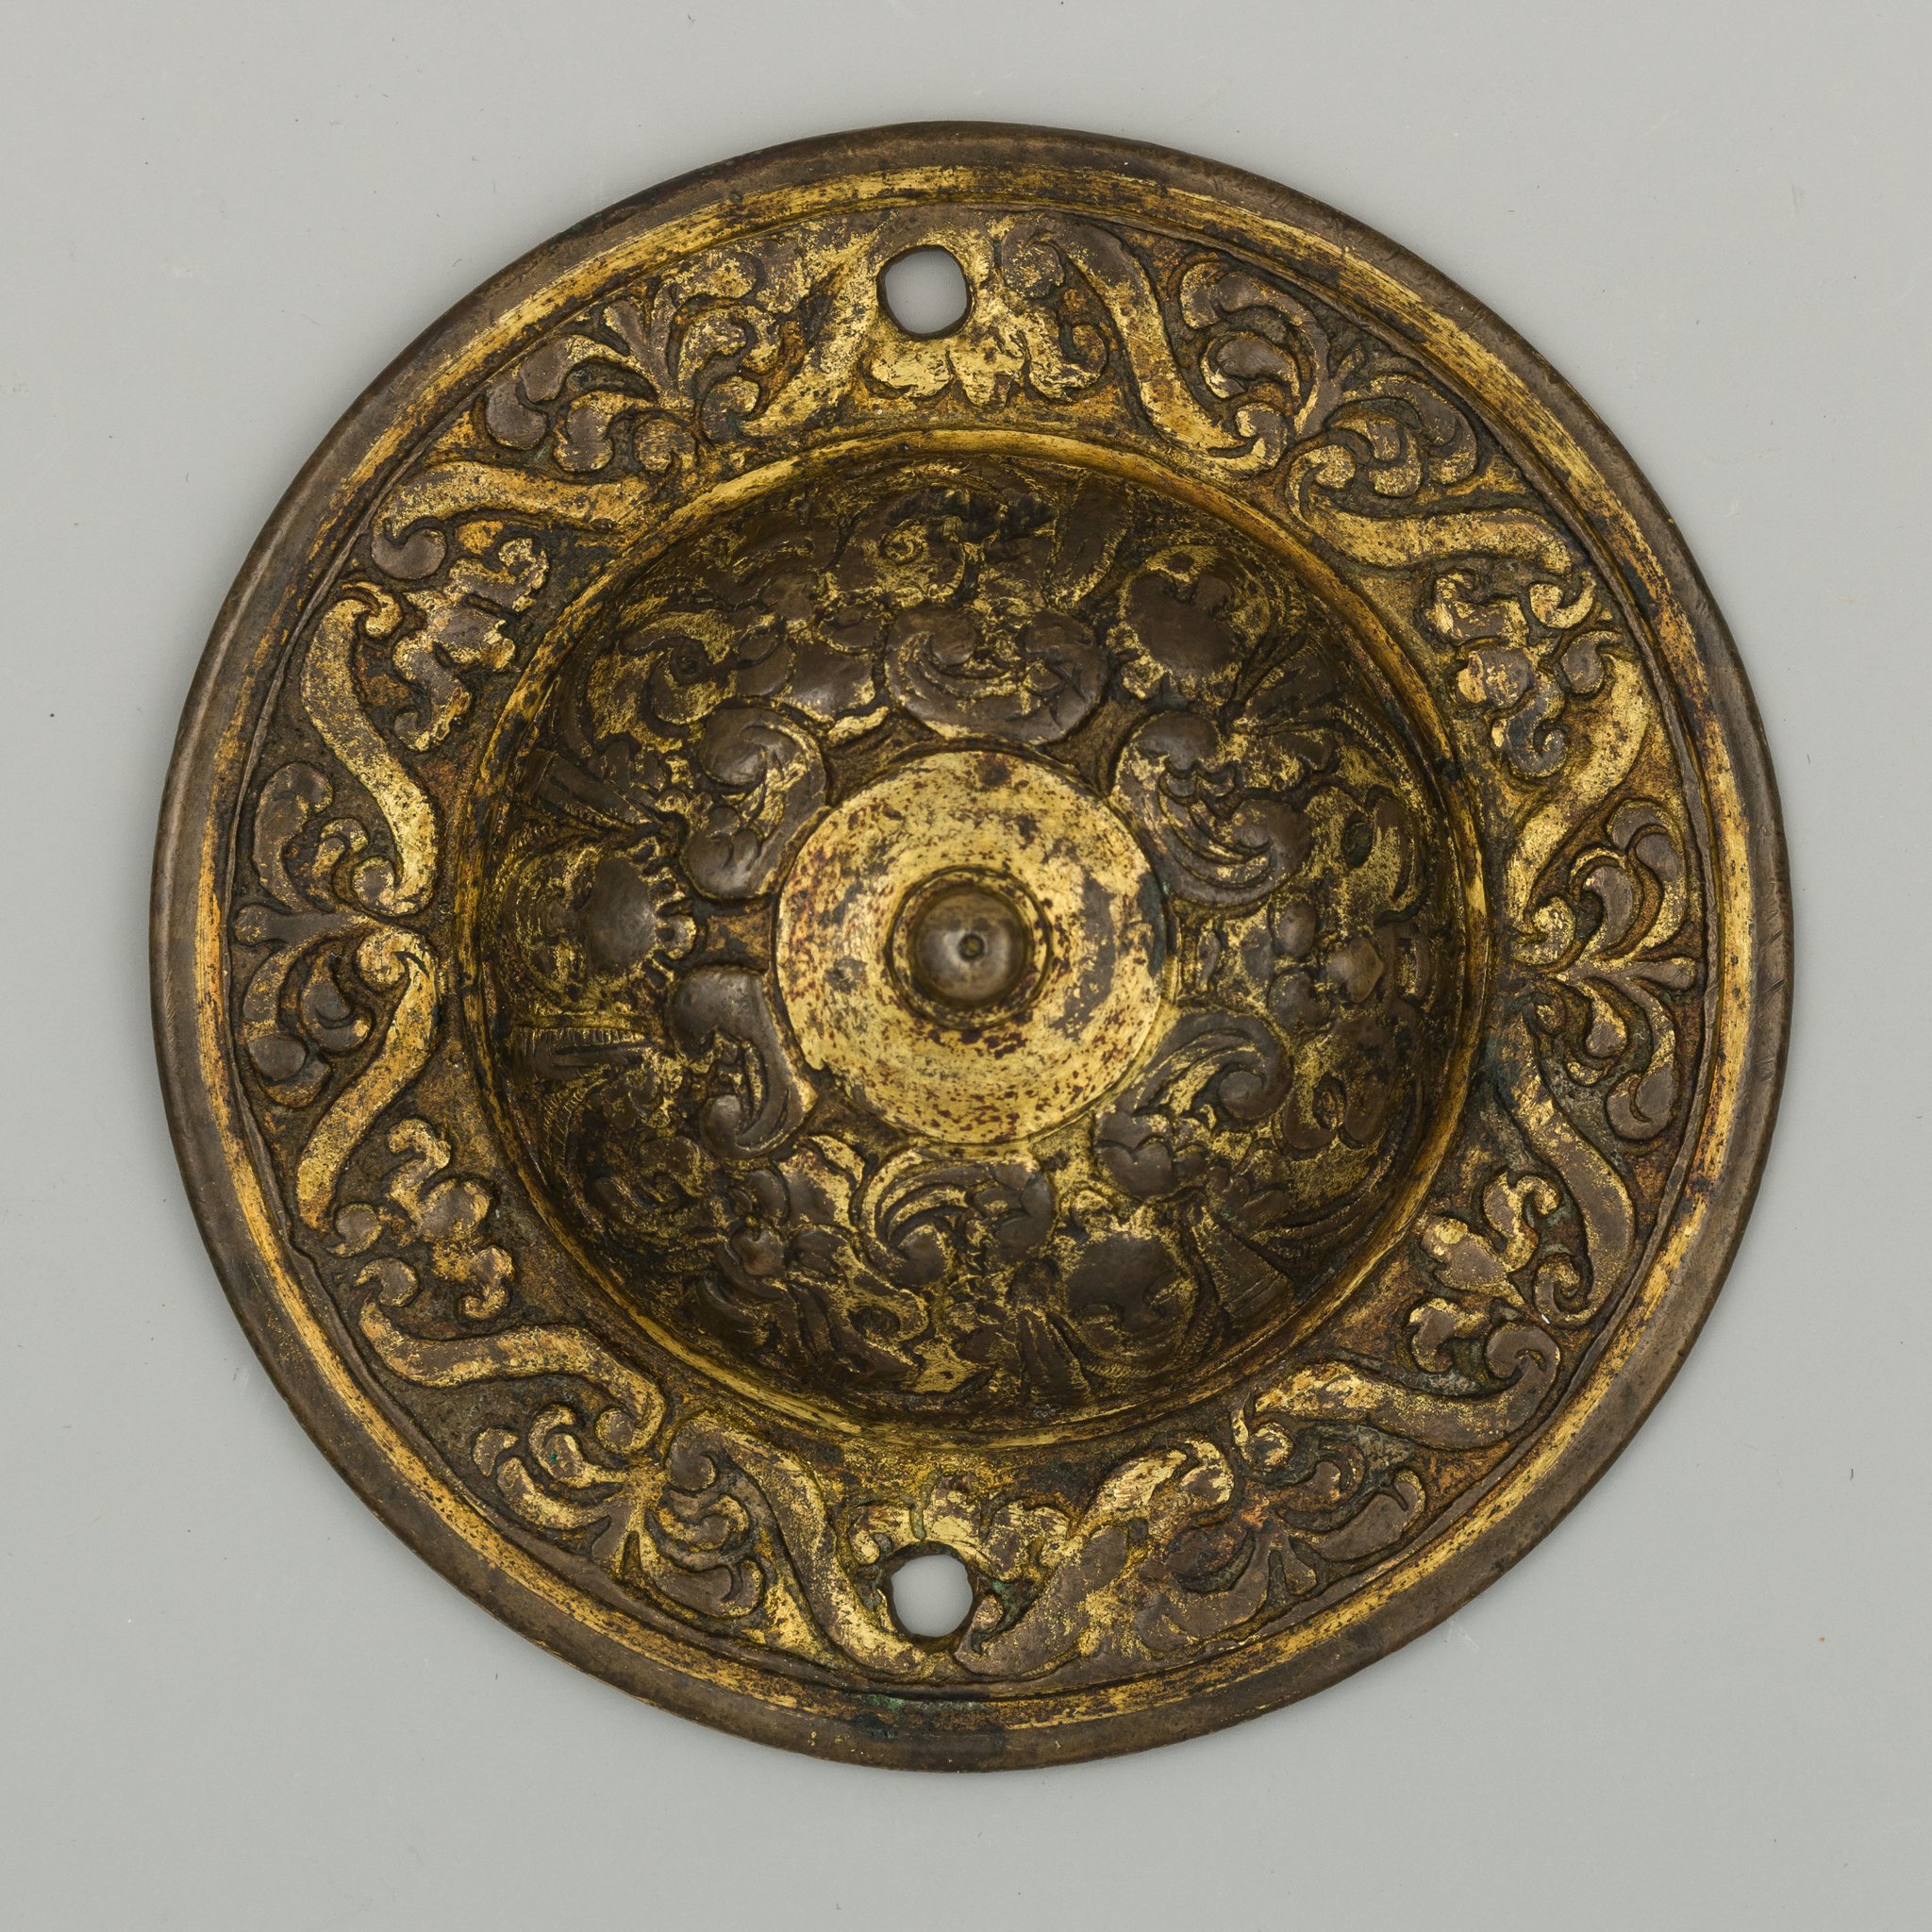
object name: bit bos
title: Bit Boss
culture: italian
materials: copper alloy, gold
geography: italy